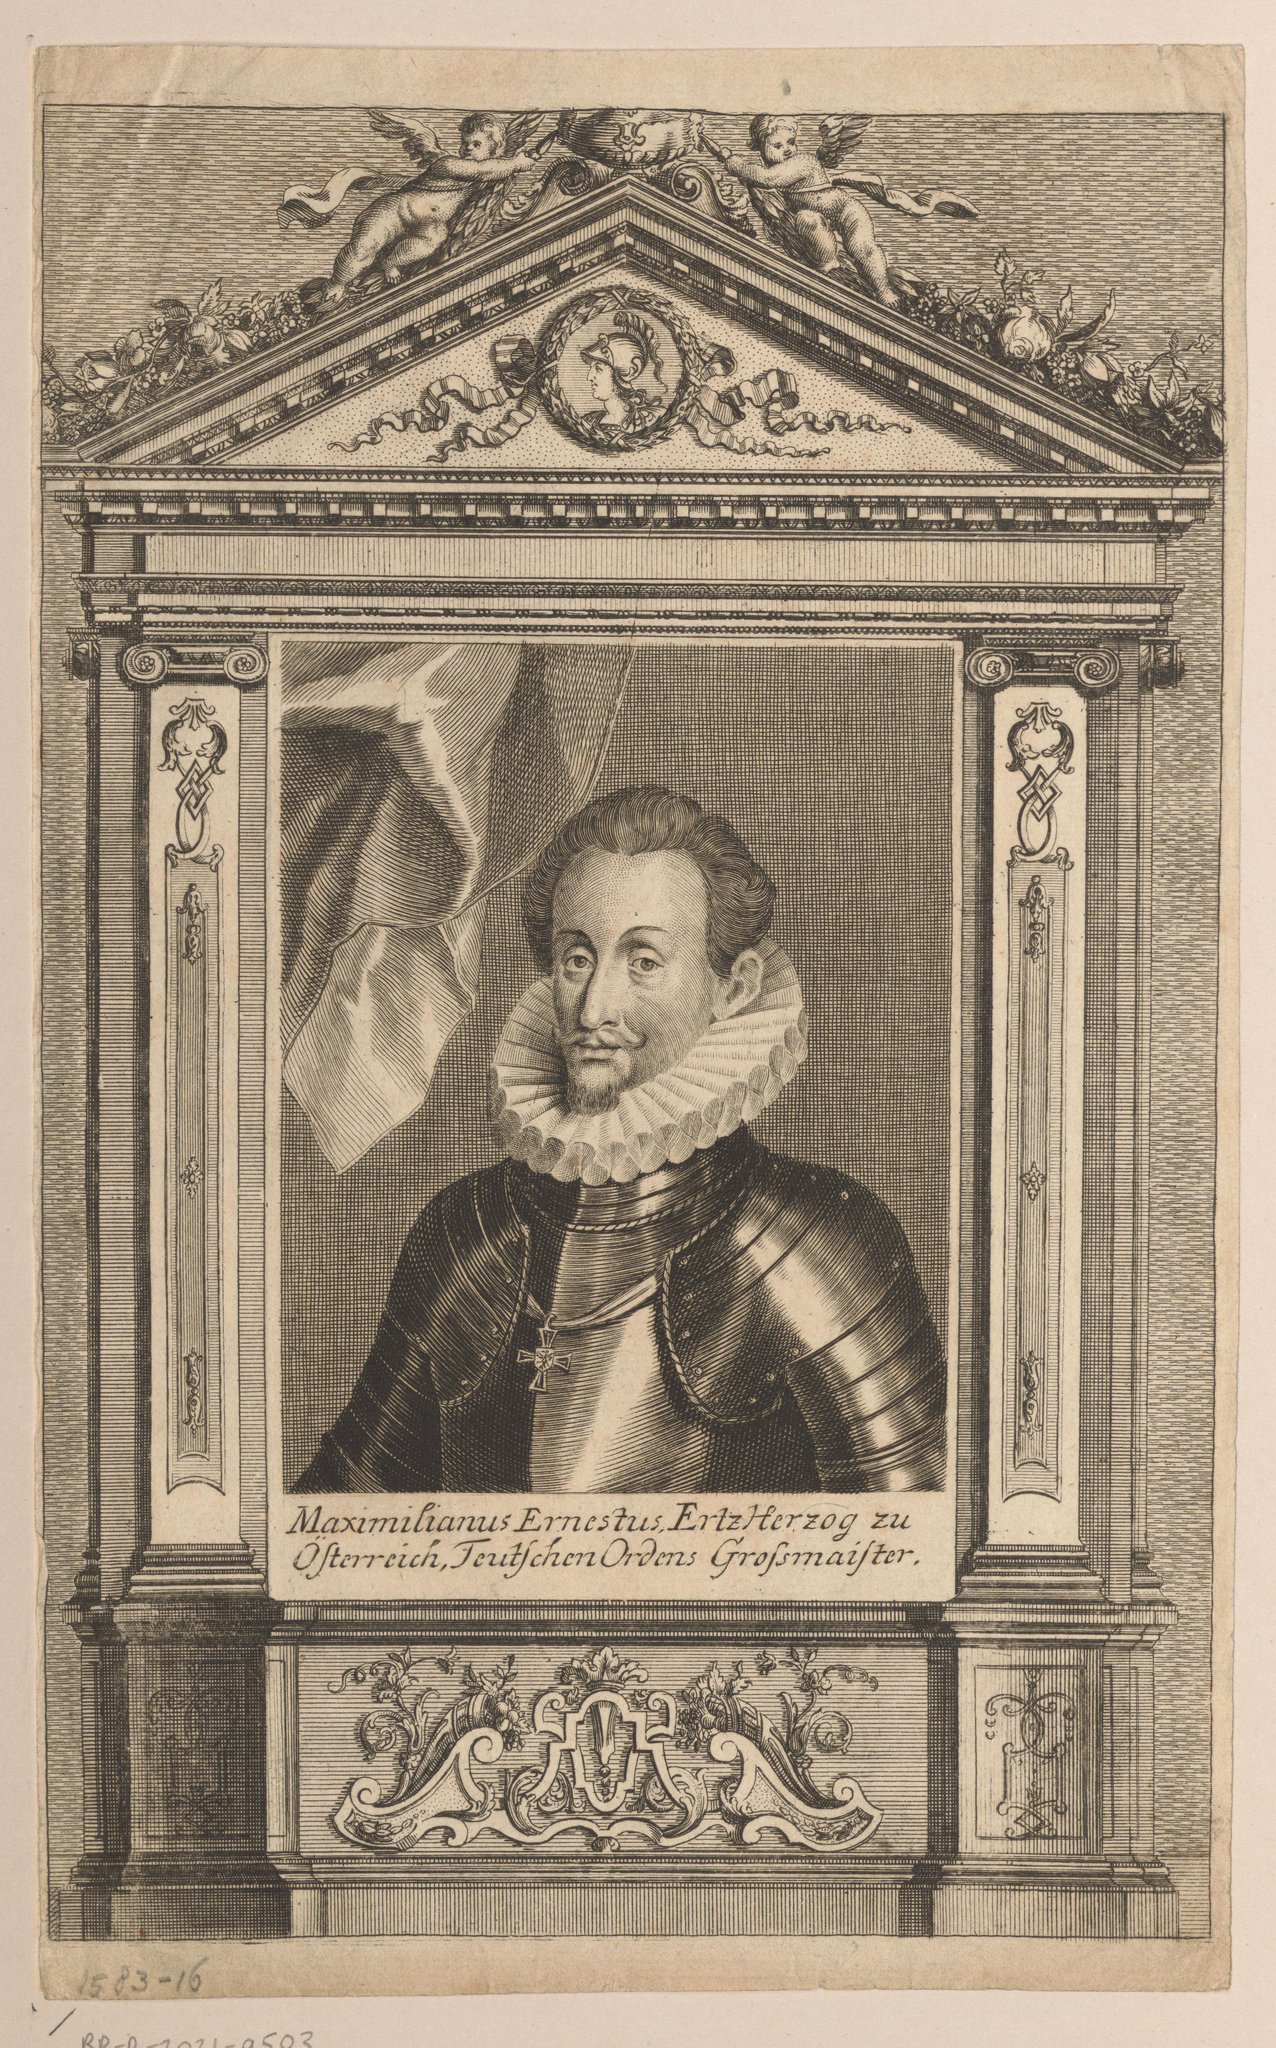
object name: book illustration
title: Portret van Maximiliaan Ernst van Oostenrijk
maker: Anonymous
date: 1721-1726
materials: paper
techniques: engraving, etching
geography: germany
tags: knighthood order: teutonic order - insignia of a knighthood order, e.g.: badge, chain (with name of order), armour, historical persons, ornament derived from architectural details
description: Prent waarschijnlijk uit een deel van: Khevenhüller, Franz Christoph. Annales Ferdinandei (...). Leipzig: Moritz Georg Weidmann, 1721-1726.